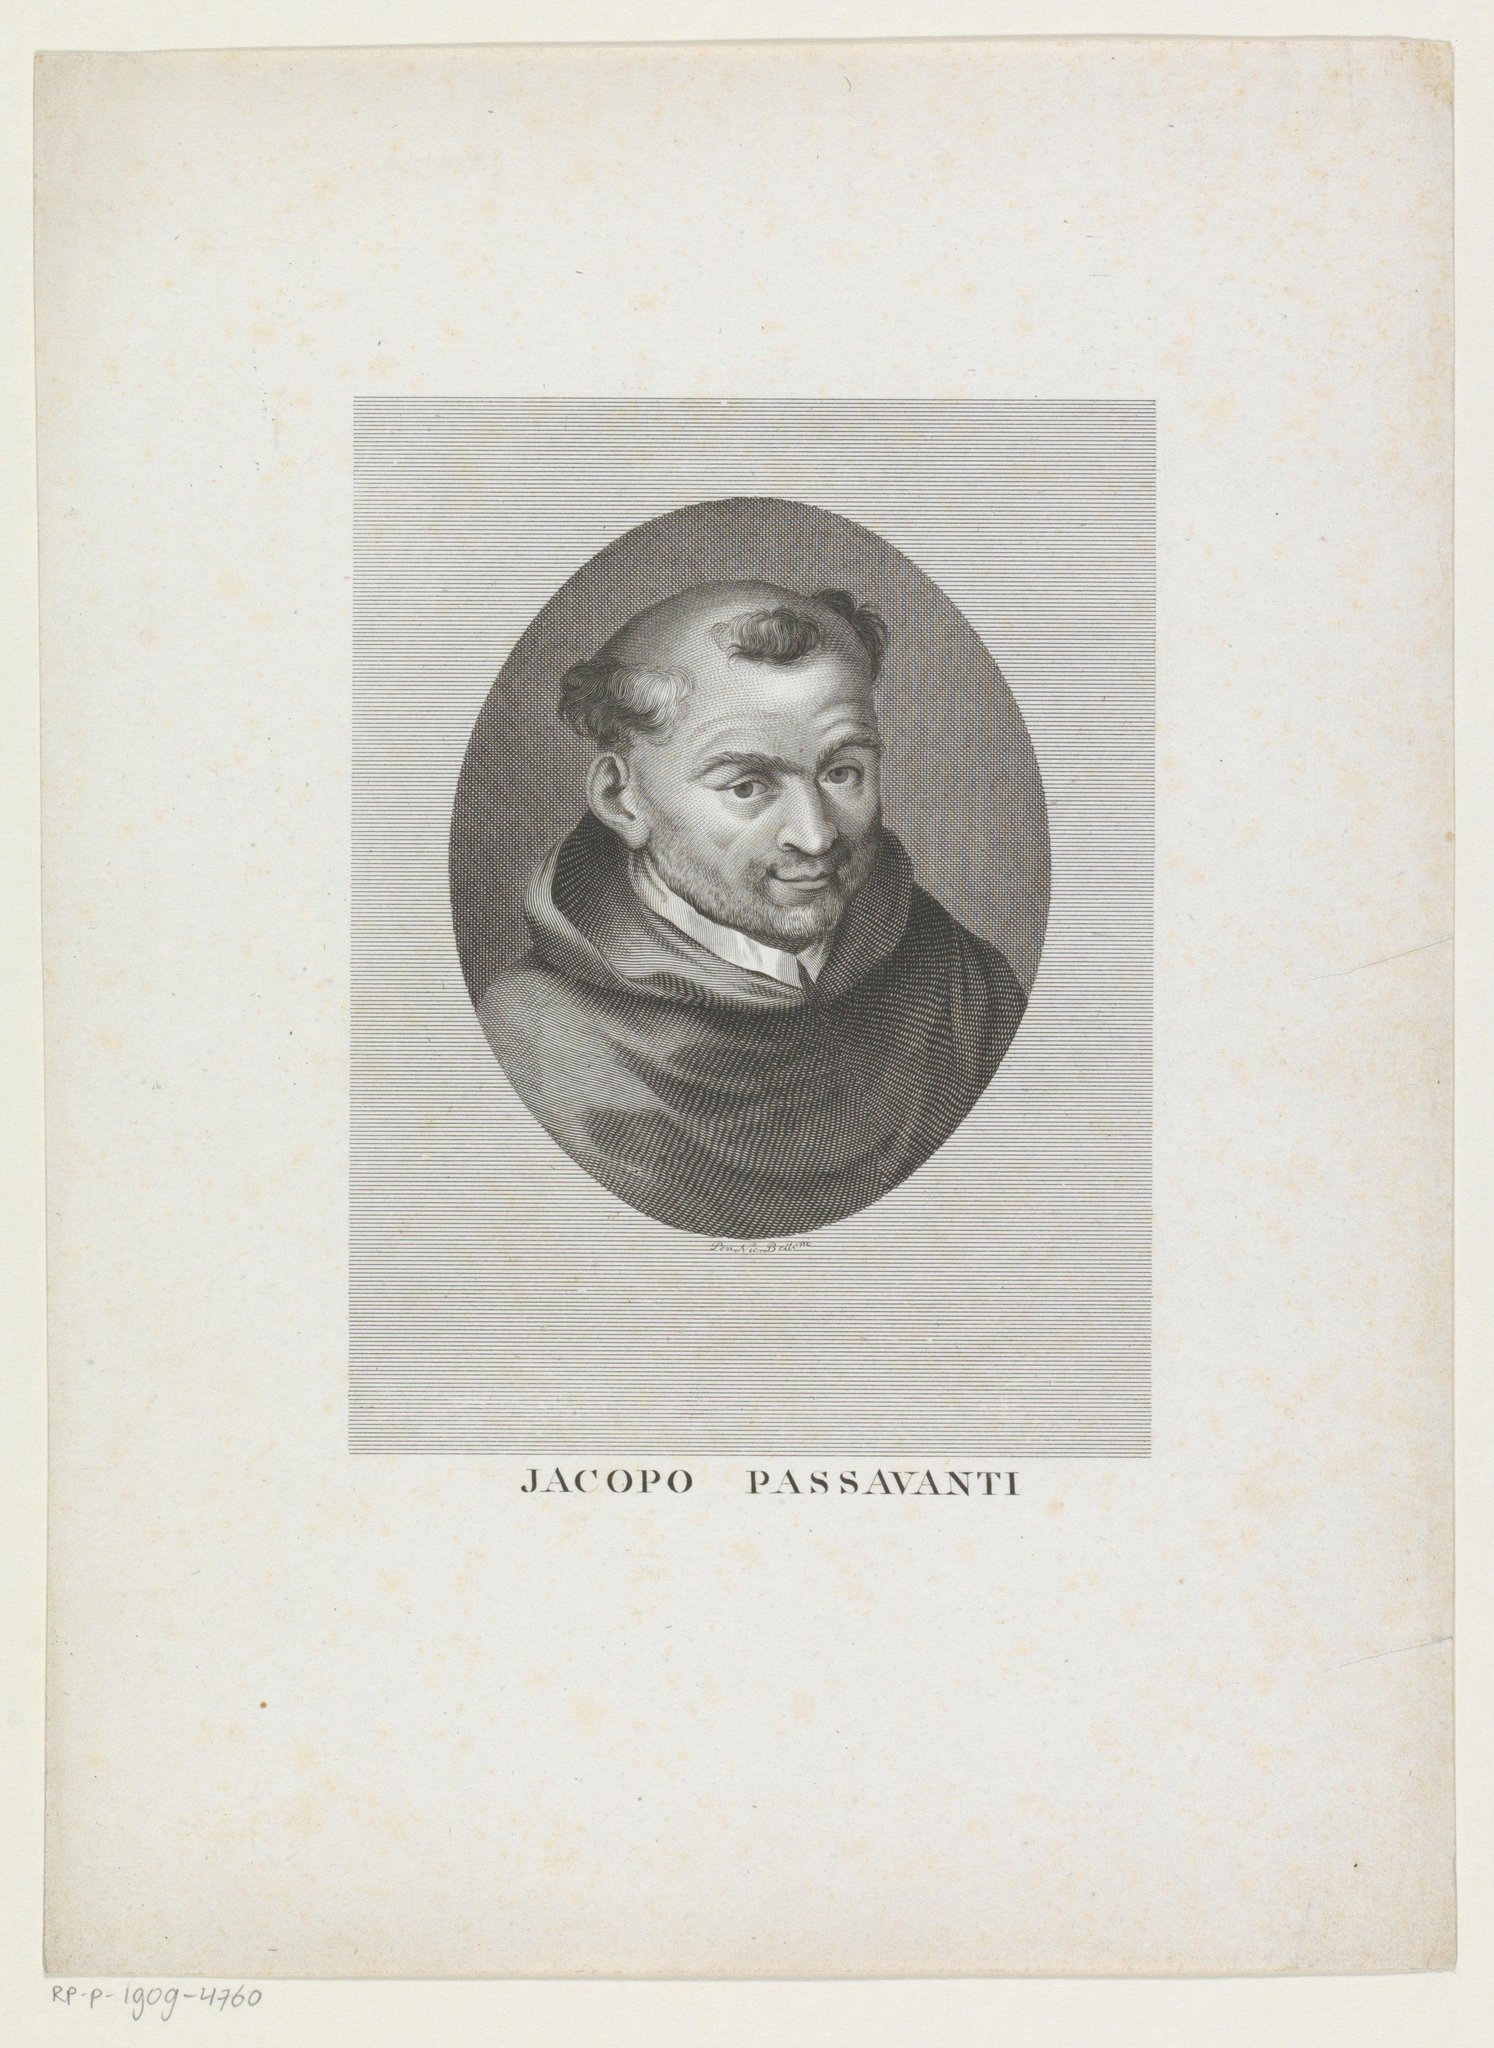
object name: print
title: Portretten van beroemde Italianen in ovalen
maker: niccolò bettoni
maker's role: print maker, publisher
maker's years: 1770-1842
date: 1800-1899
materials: paper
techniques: engraving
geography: italy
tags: historical persons, portrait of a writer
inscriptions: collector's mark: Lugt 2228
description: Deze prent maakt deel uit van een reeks portretprenten van onbekende omvang. De reeks is in meerdere staten uitgegeven. De eerste staat met enkel het portret in ovaal. Een tweede staat met naam van de geportretteerde in holle letters onder de voorstelling. Een derde staat met de naam van de geportretteerde in gevulde letters onder de voorstelling. En een vierde staat met een rechthoekig kader rondom het ovale portret.